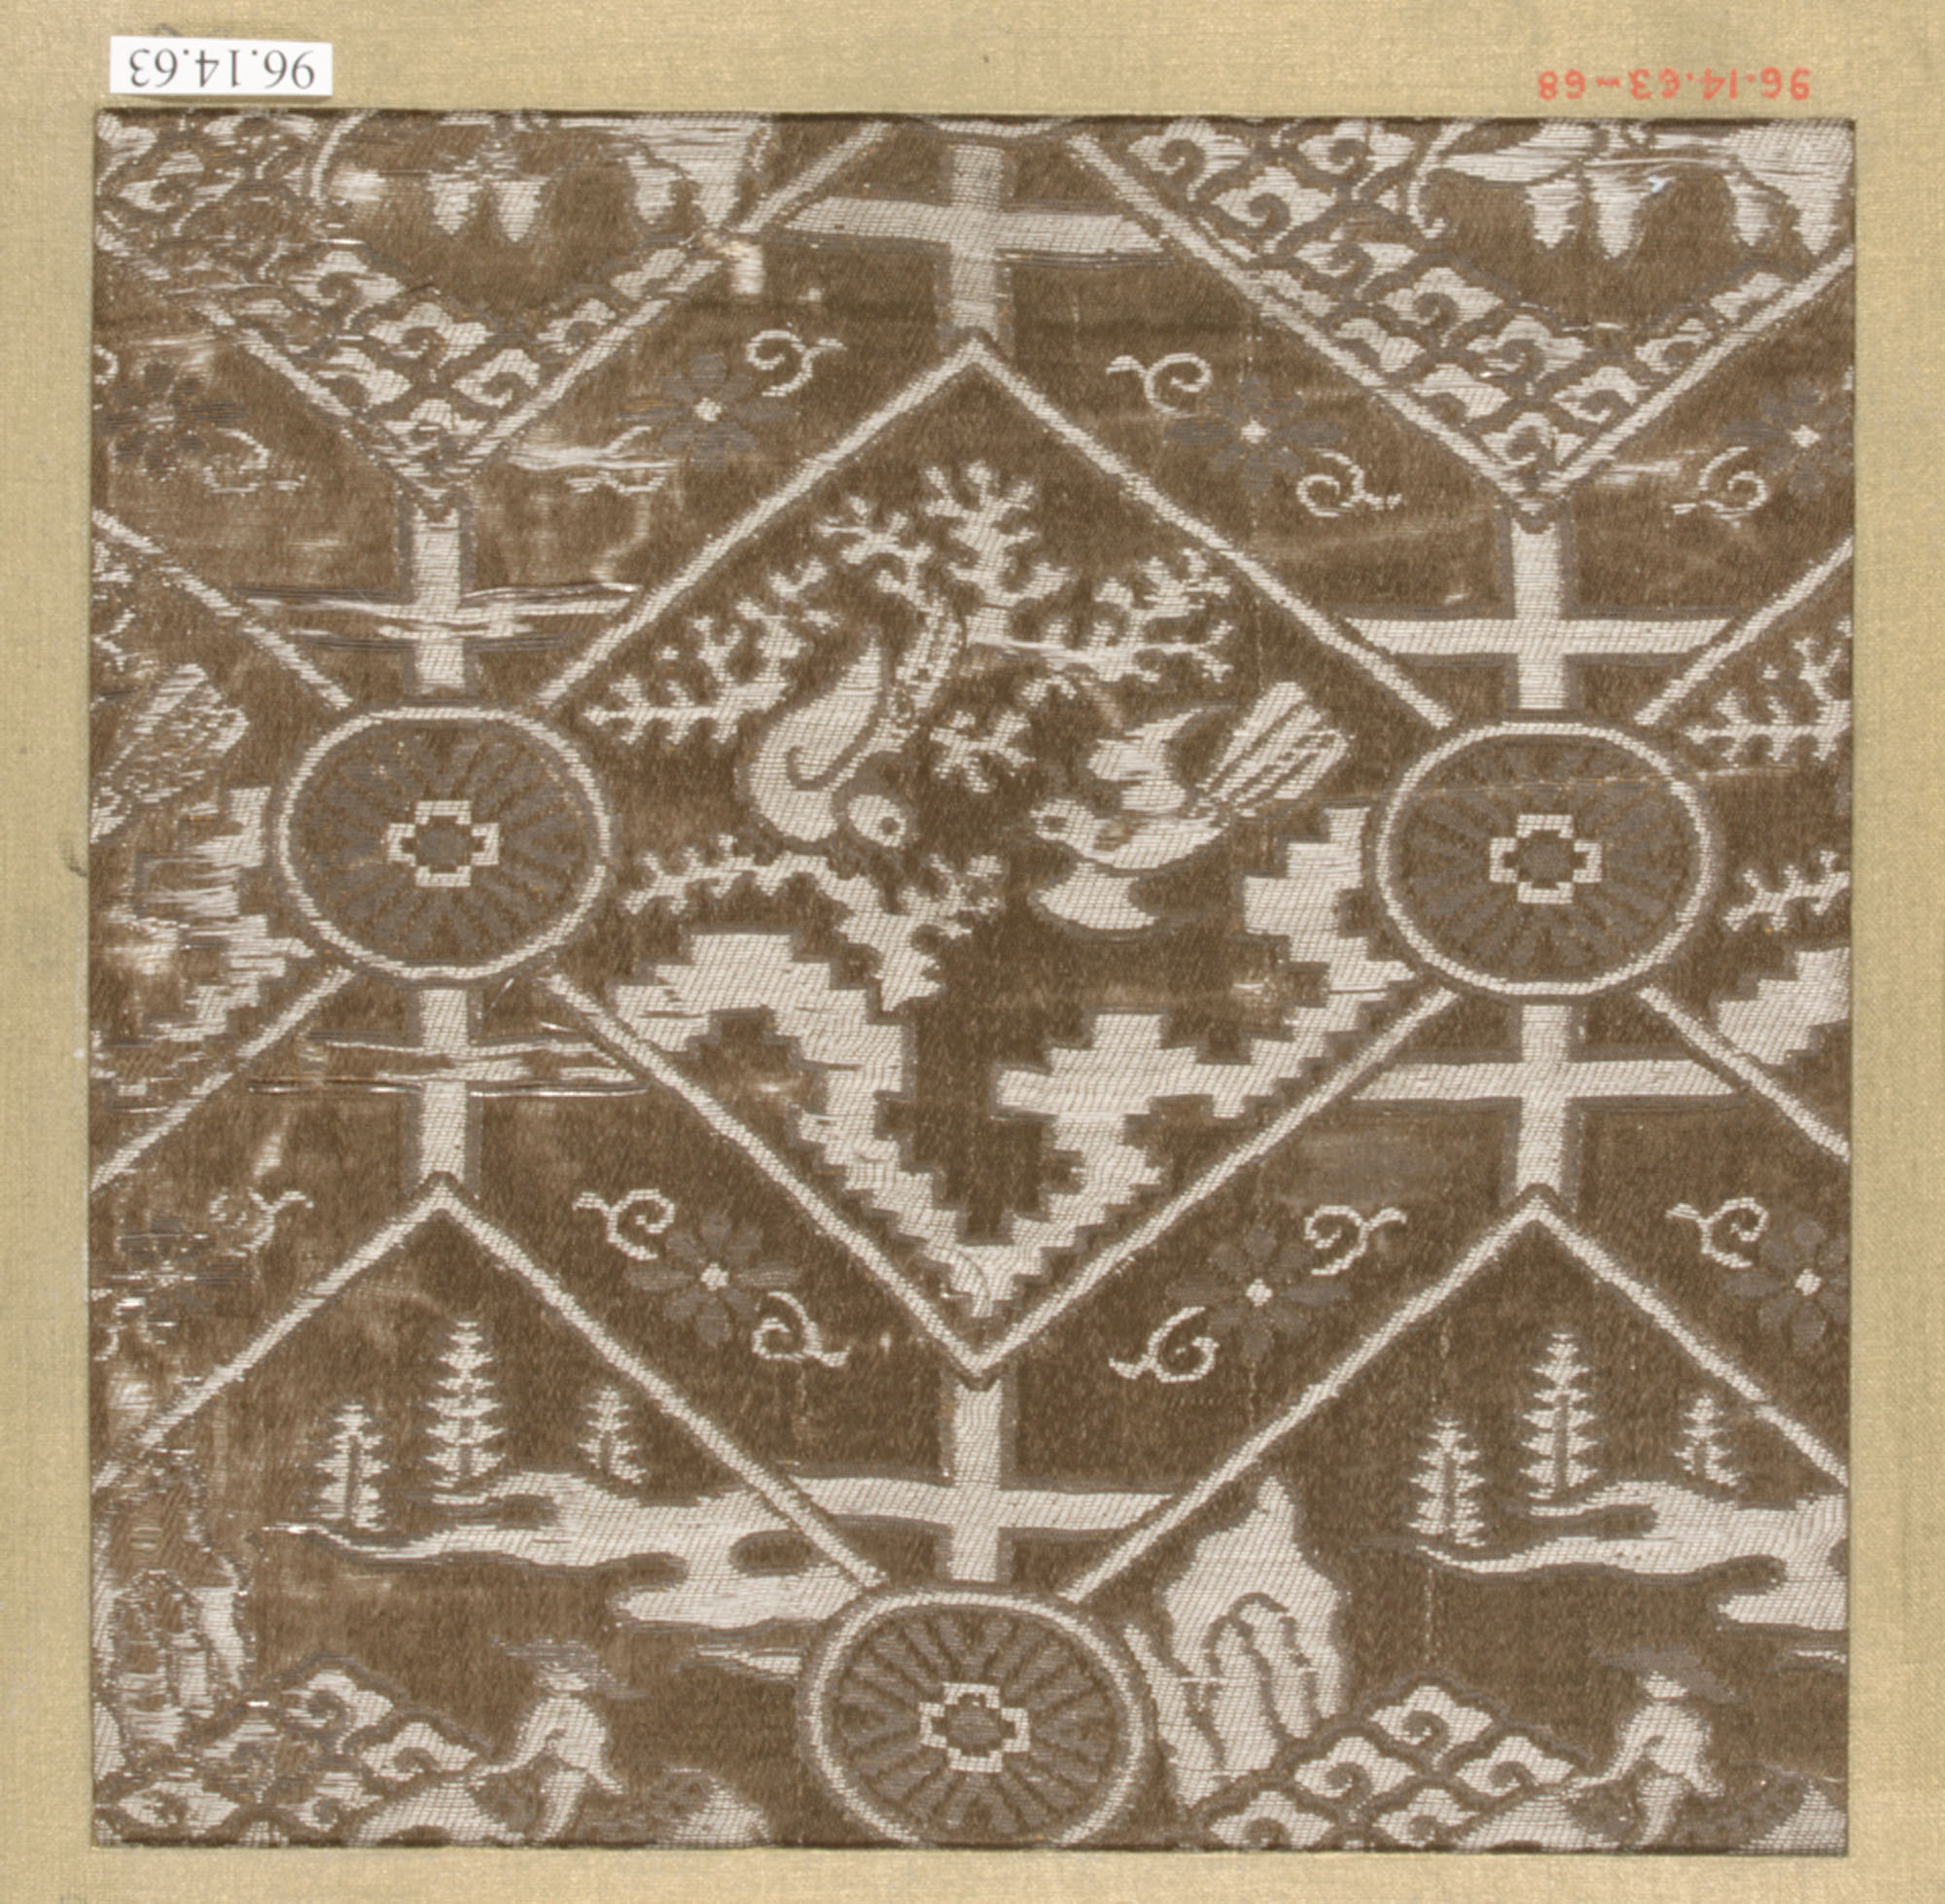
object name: piece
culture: japanese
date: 1701-1800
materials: silk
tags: birds